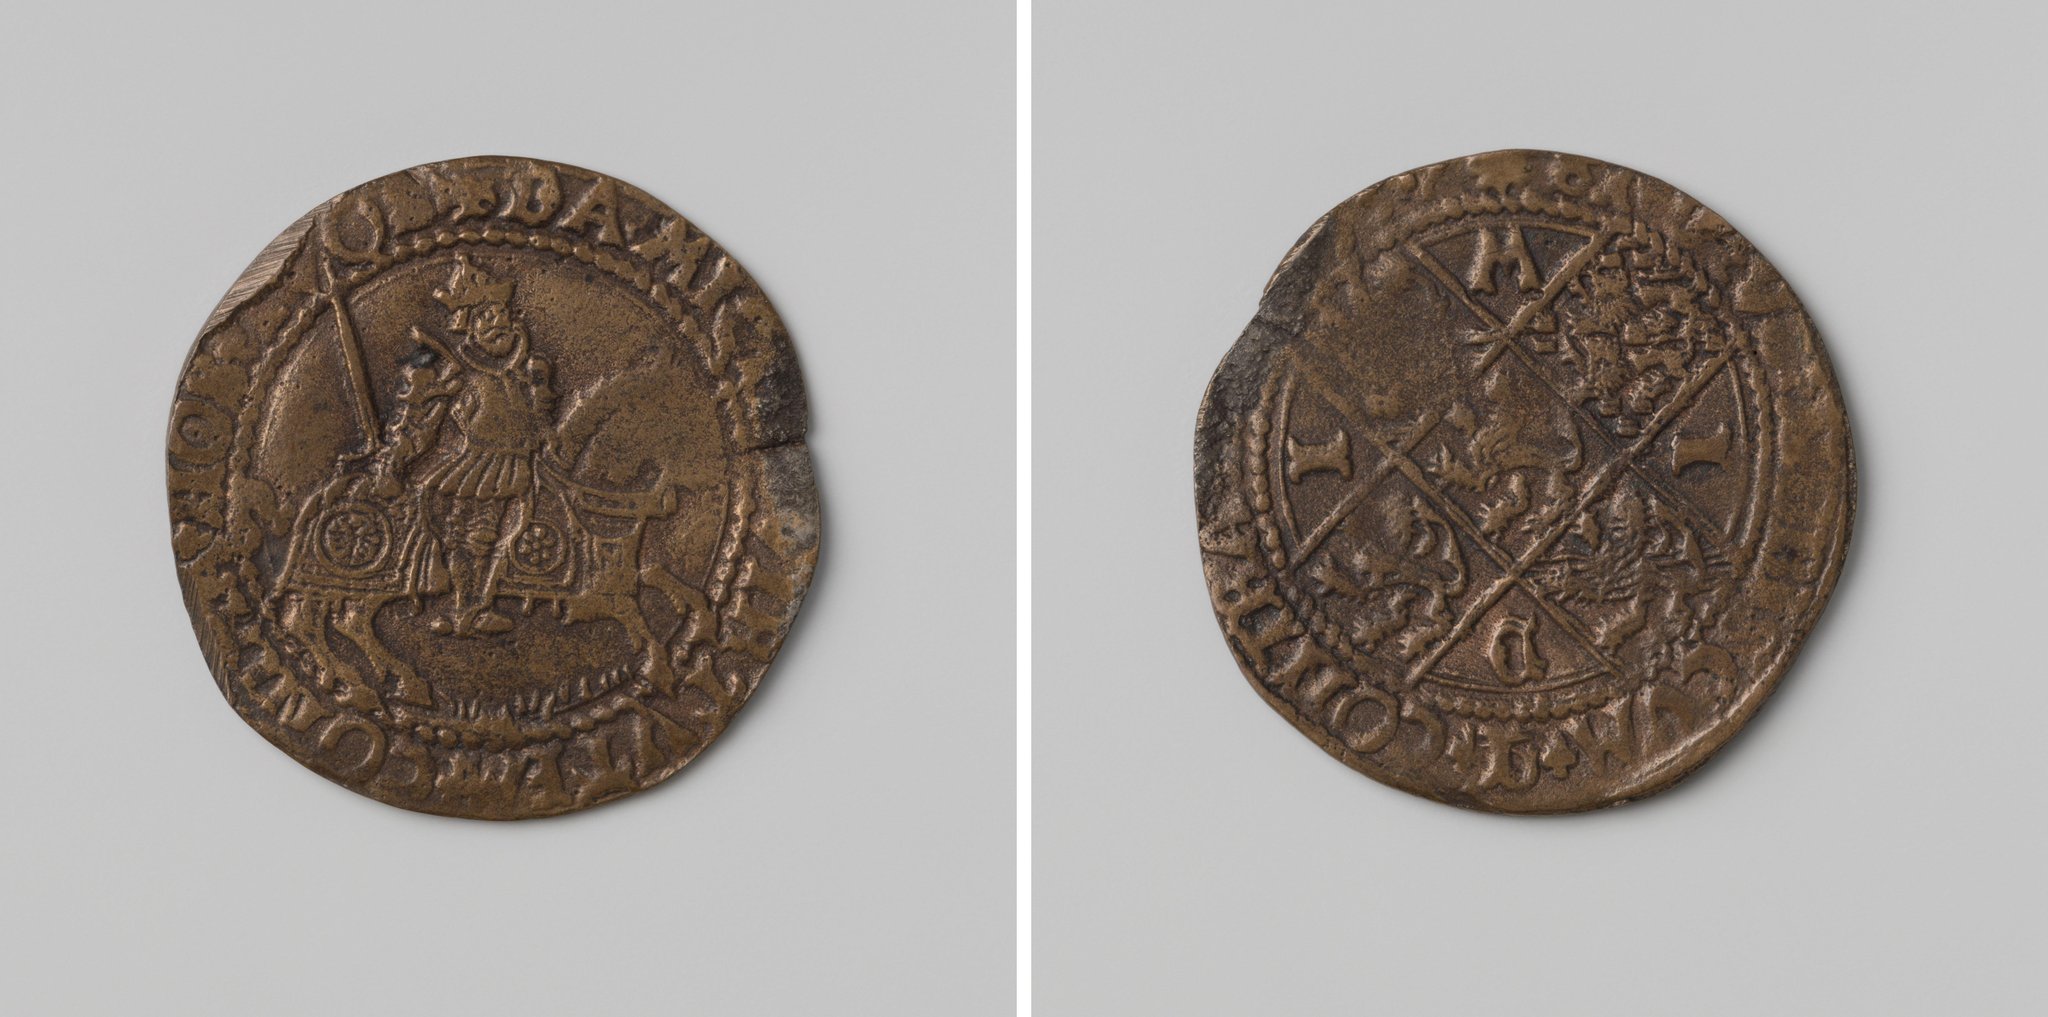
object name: jeton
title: Karel V, Duits keizer, bereidt zich voor op de oorlog tegen de Turken, rekenpenning ten behoeve van Mr. Jacob de Jonge, auditeur van de rekenkamer van Holland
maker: Anonymous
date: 1538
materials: copper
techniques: striking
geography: netherlands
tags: ghent, charles v (holy roman emperor and king of spain), holland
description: Koperen penning. Voorzijde: Karel V te paard, met kroon op hoofd en getrokken zwaard in rechterhand binnen omschrift. Keerzijde: vijf in diagonaal kruis geplaatste wapenschilden; daartussen: letters M, I, D en I binnen omschrift